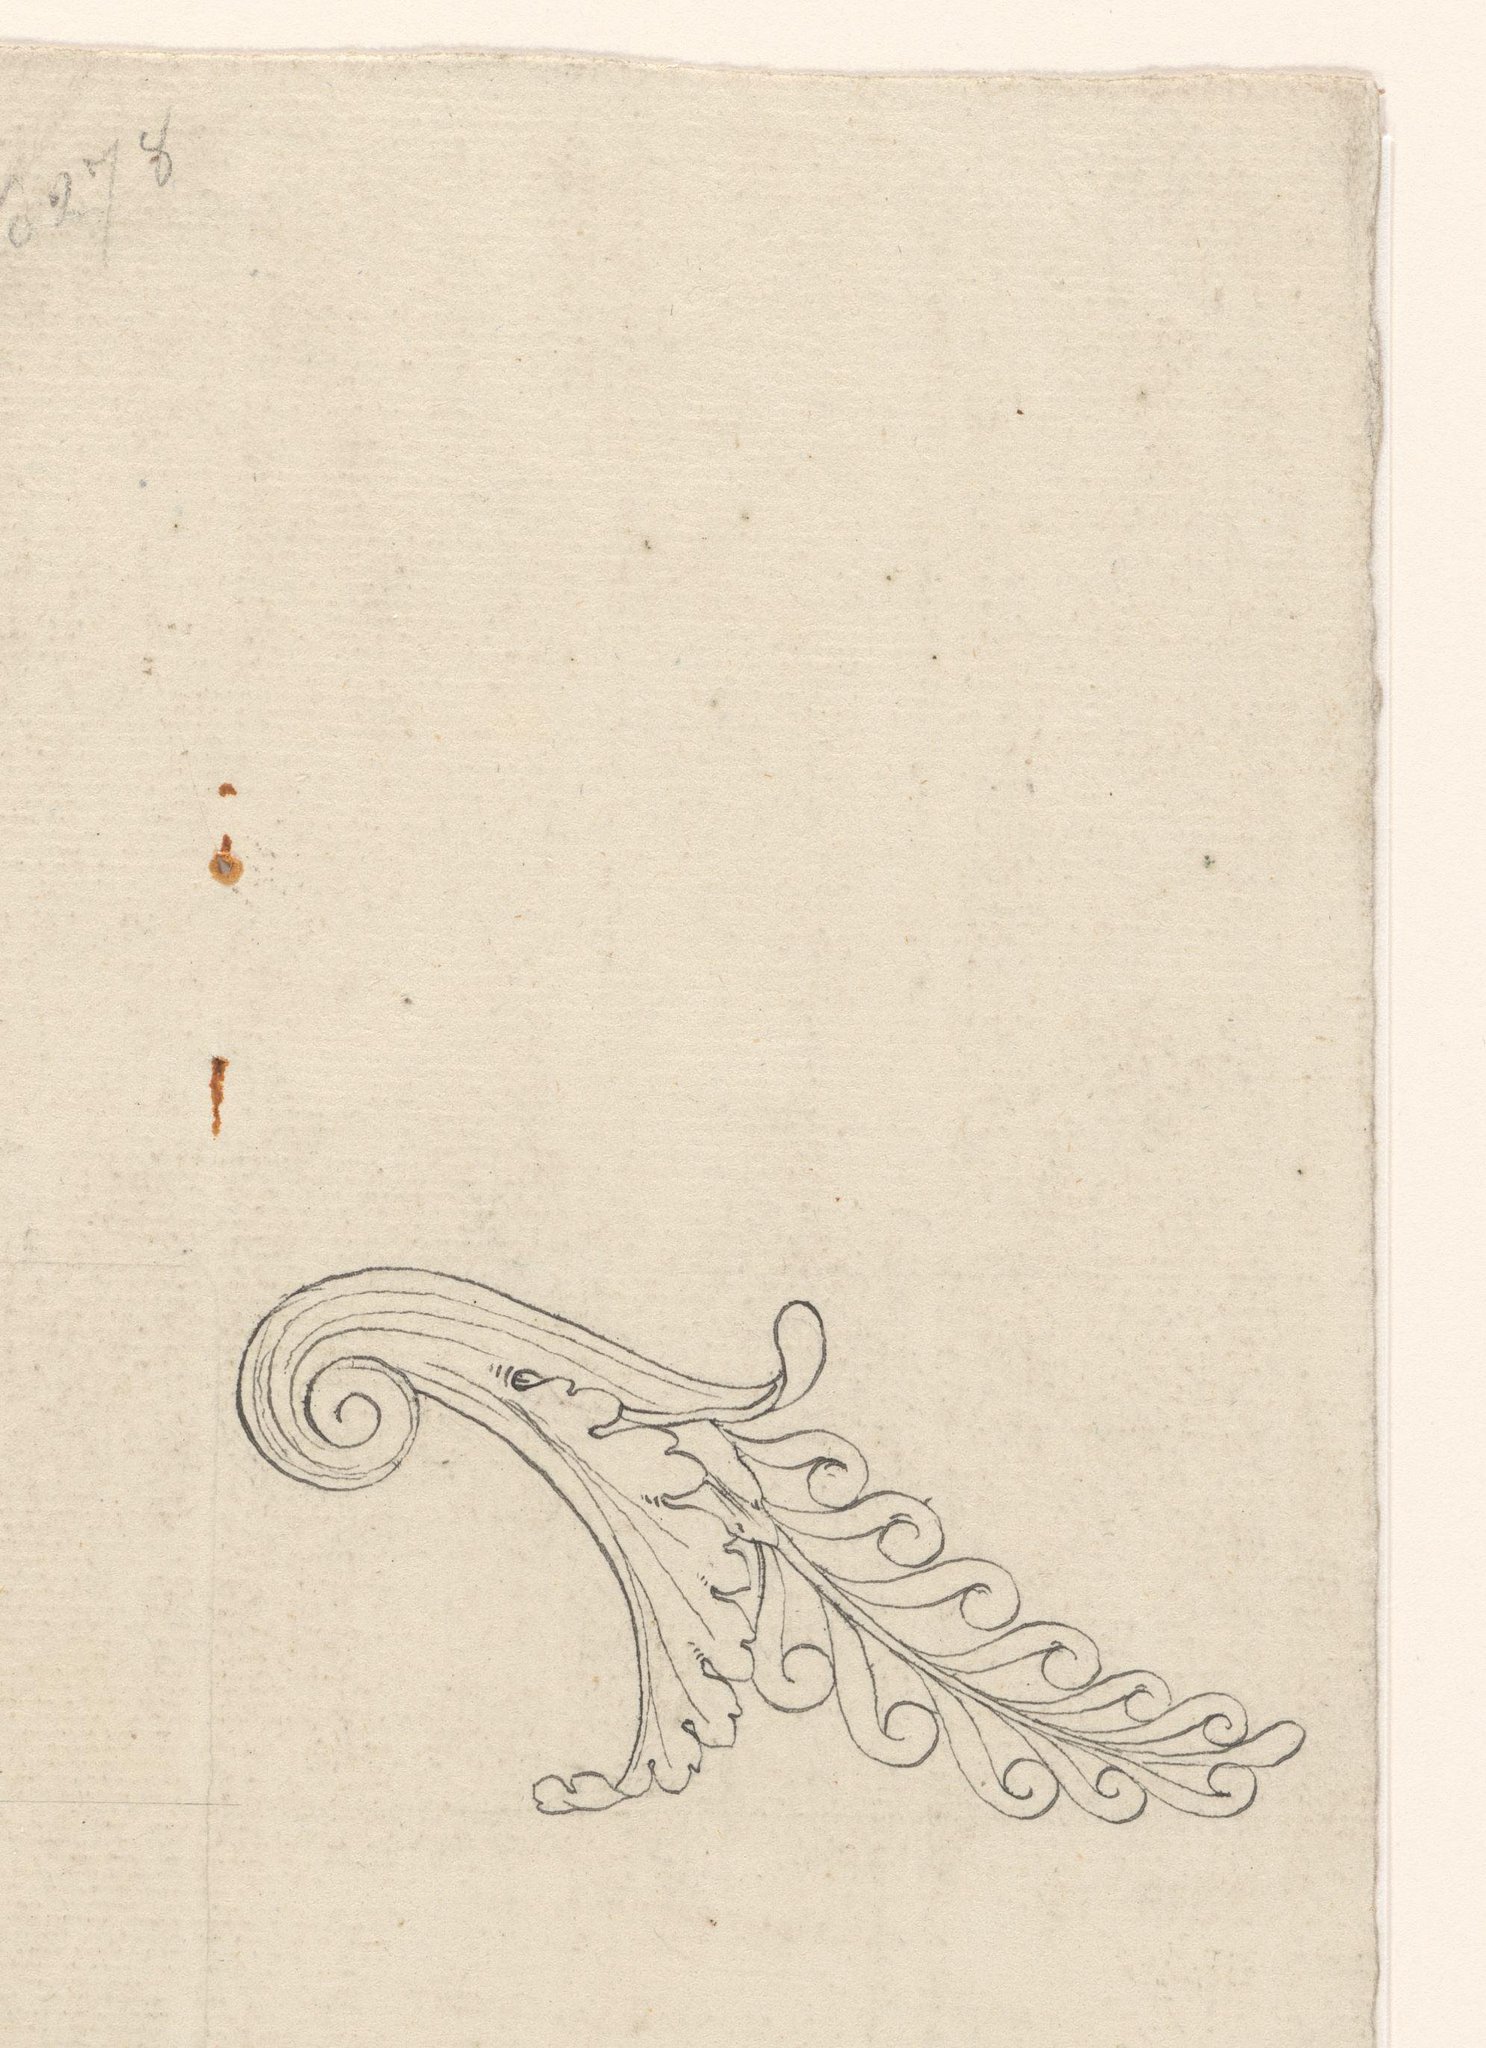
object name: design drawing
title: Gedraaid palmetmotief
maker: Anonymous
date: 1800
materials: ink, paper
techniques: pen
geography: paris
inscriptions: watermark, number: ‘No 278’